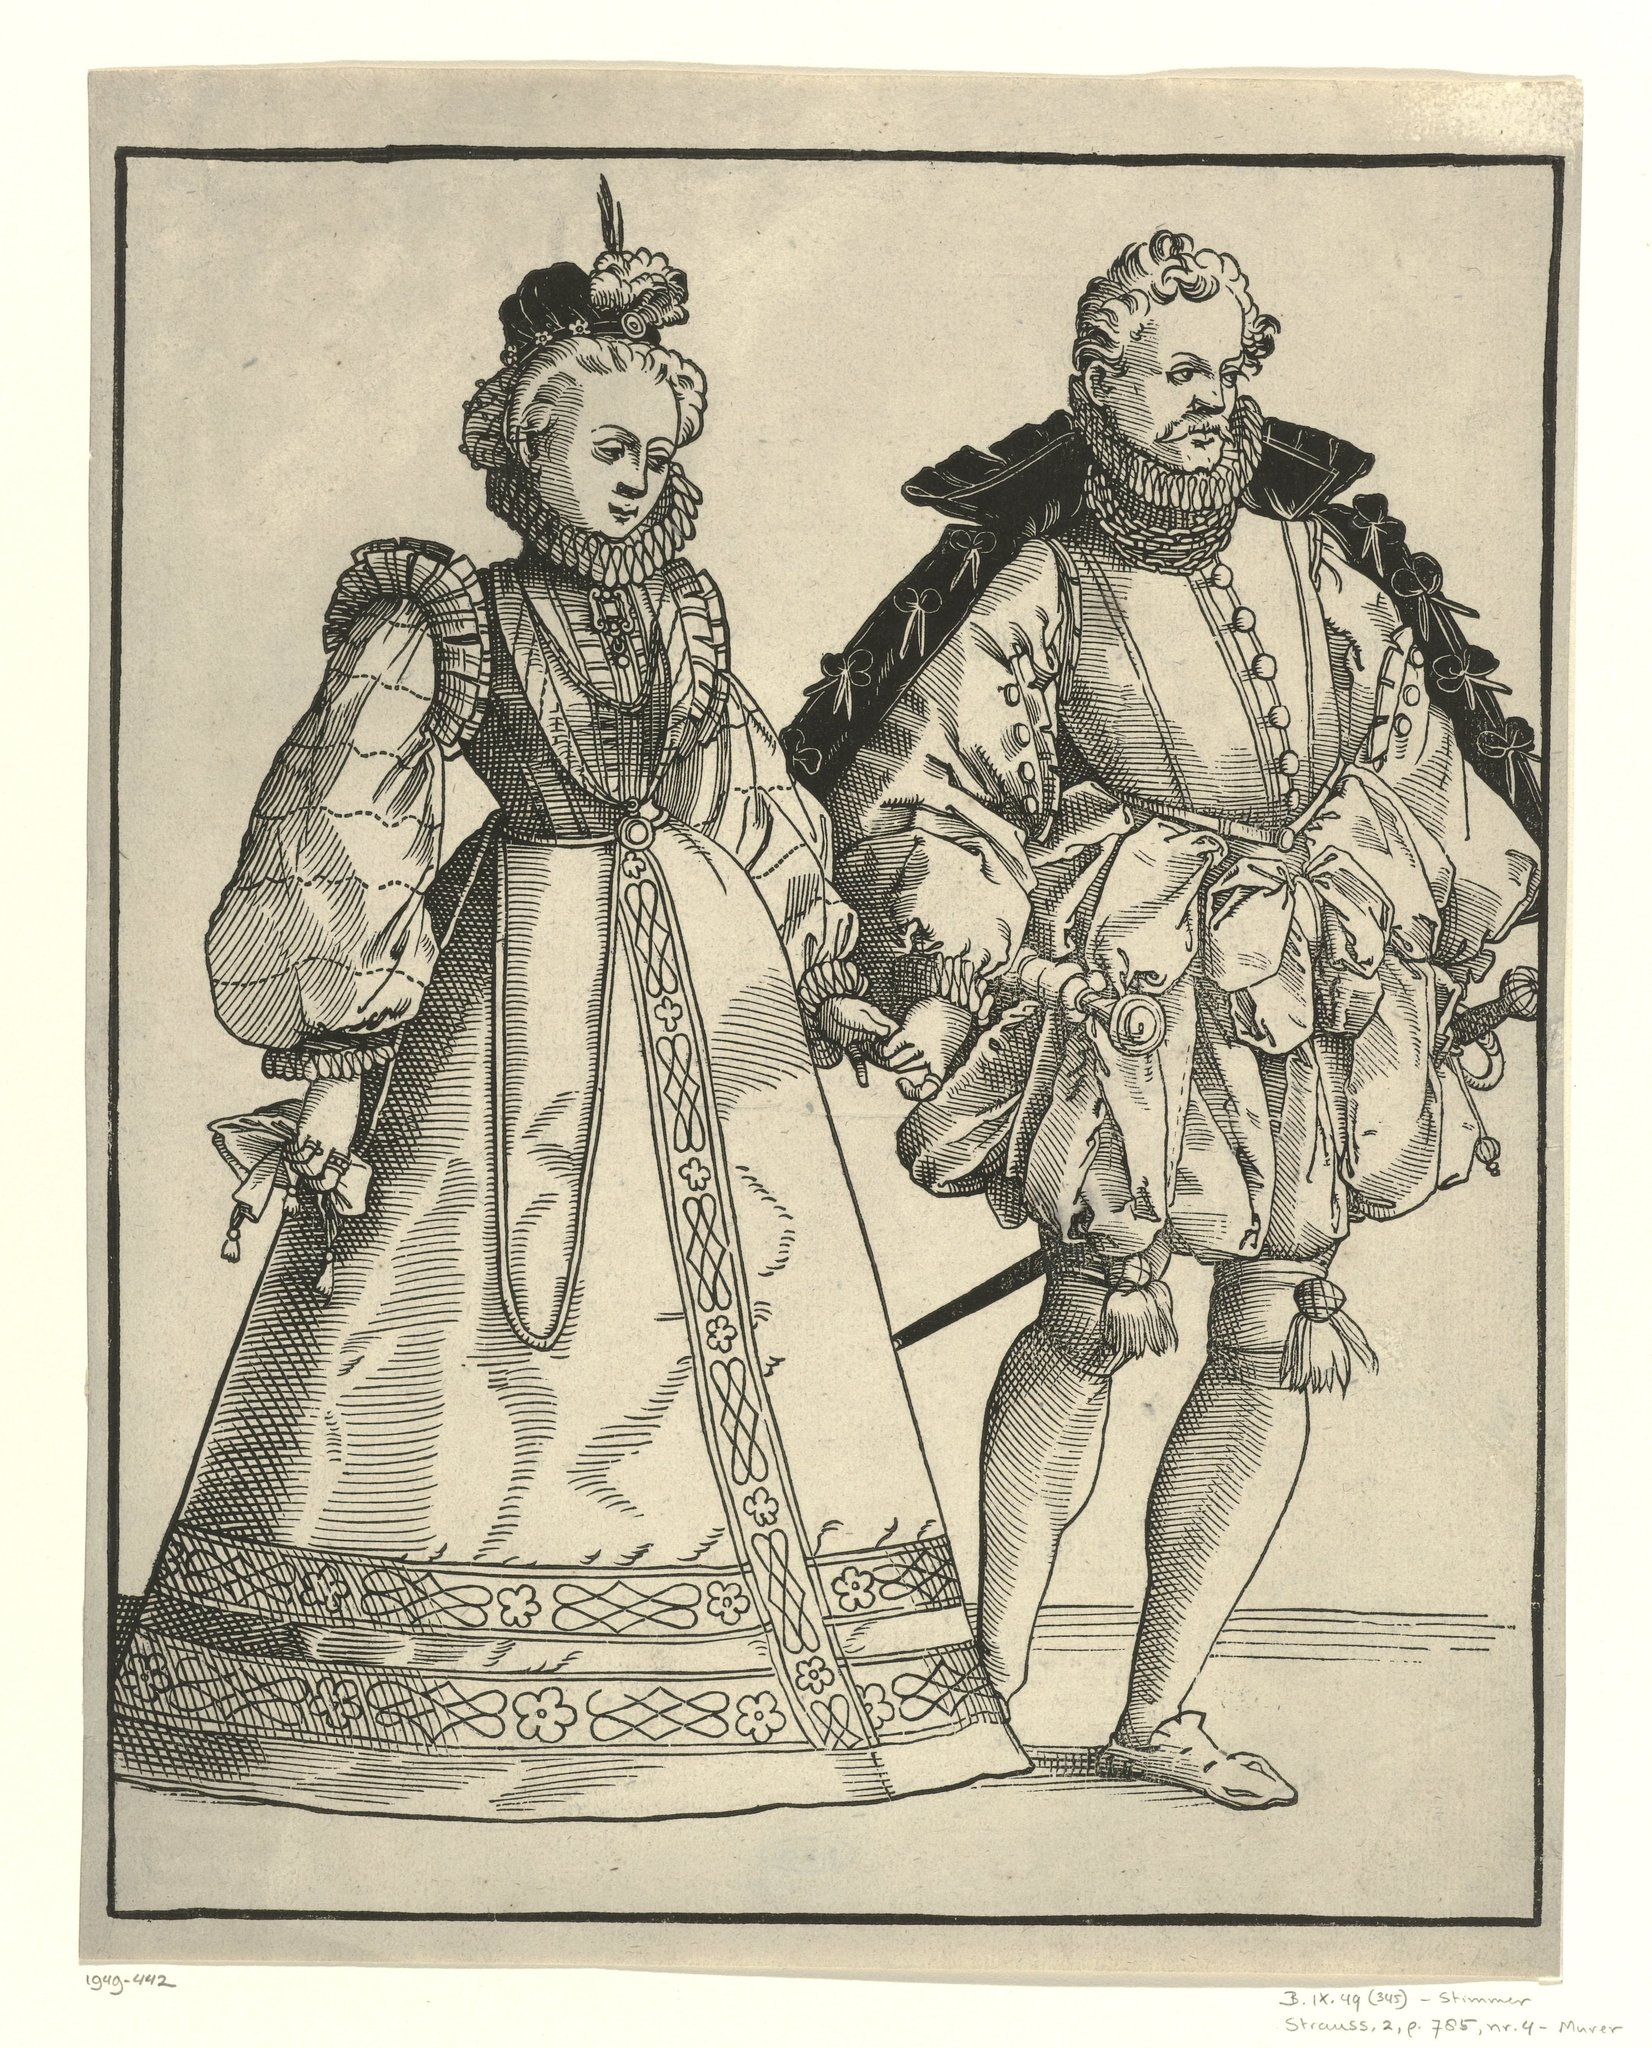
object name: print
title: Bal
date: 1550-1585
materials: paper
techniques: woodcut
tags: cape (+ men's clothes), clothing for the upper part of the body (doublet) (+ men's clothes), europeans: germans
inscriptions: collector's mark: Lugt 2228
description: Het paar in Duitse hofkleding, vormt met vijf andere paren (niet aanwezig RPK) een hofdans. Man en vrouw zijn gekleed volgens de Spaanse mode die aan het eind van de 16de eeuw overal in Europa werd gevolgd. De man draagt Pluderhose.